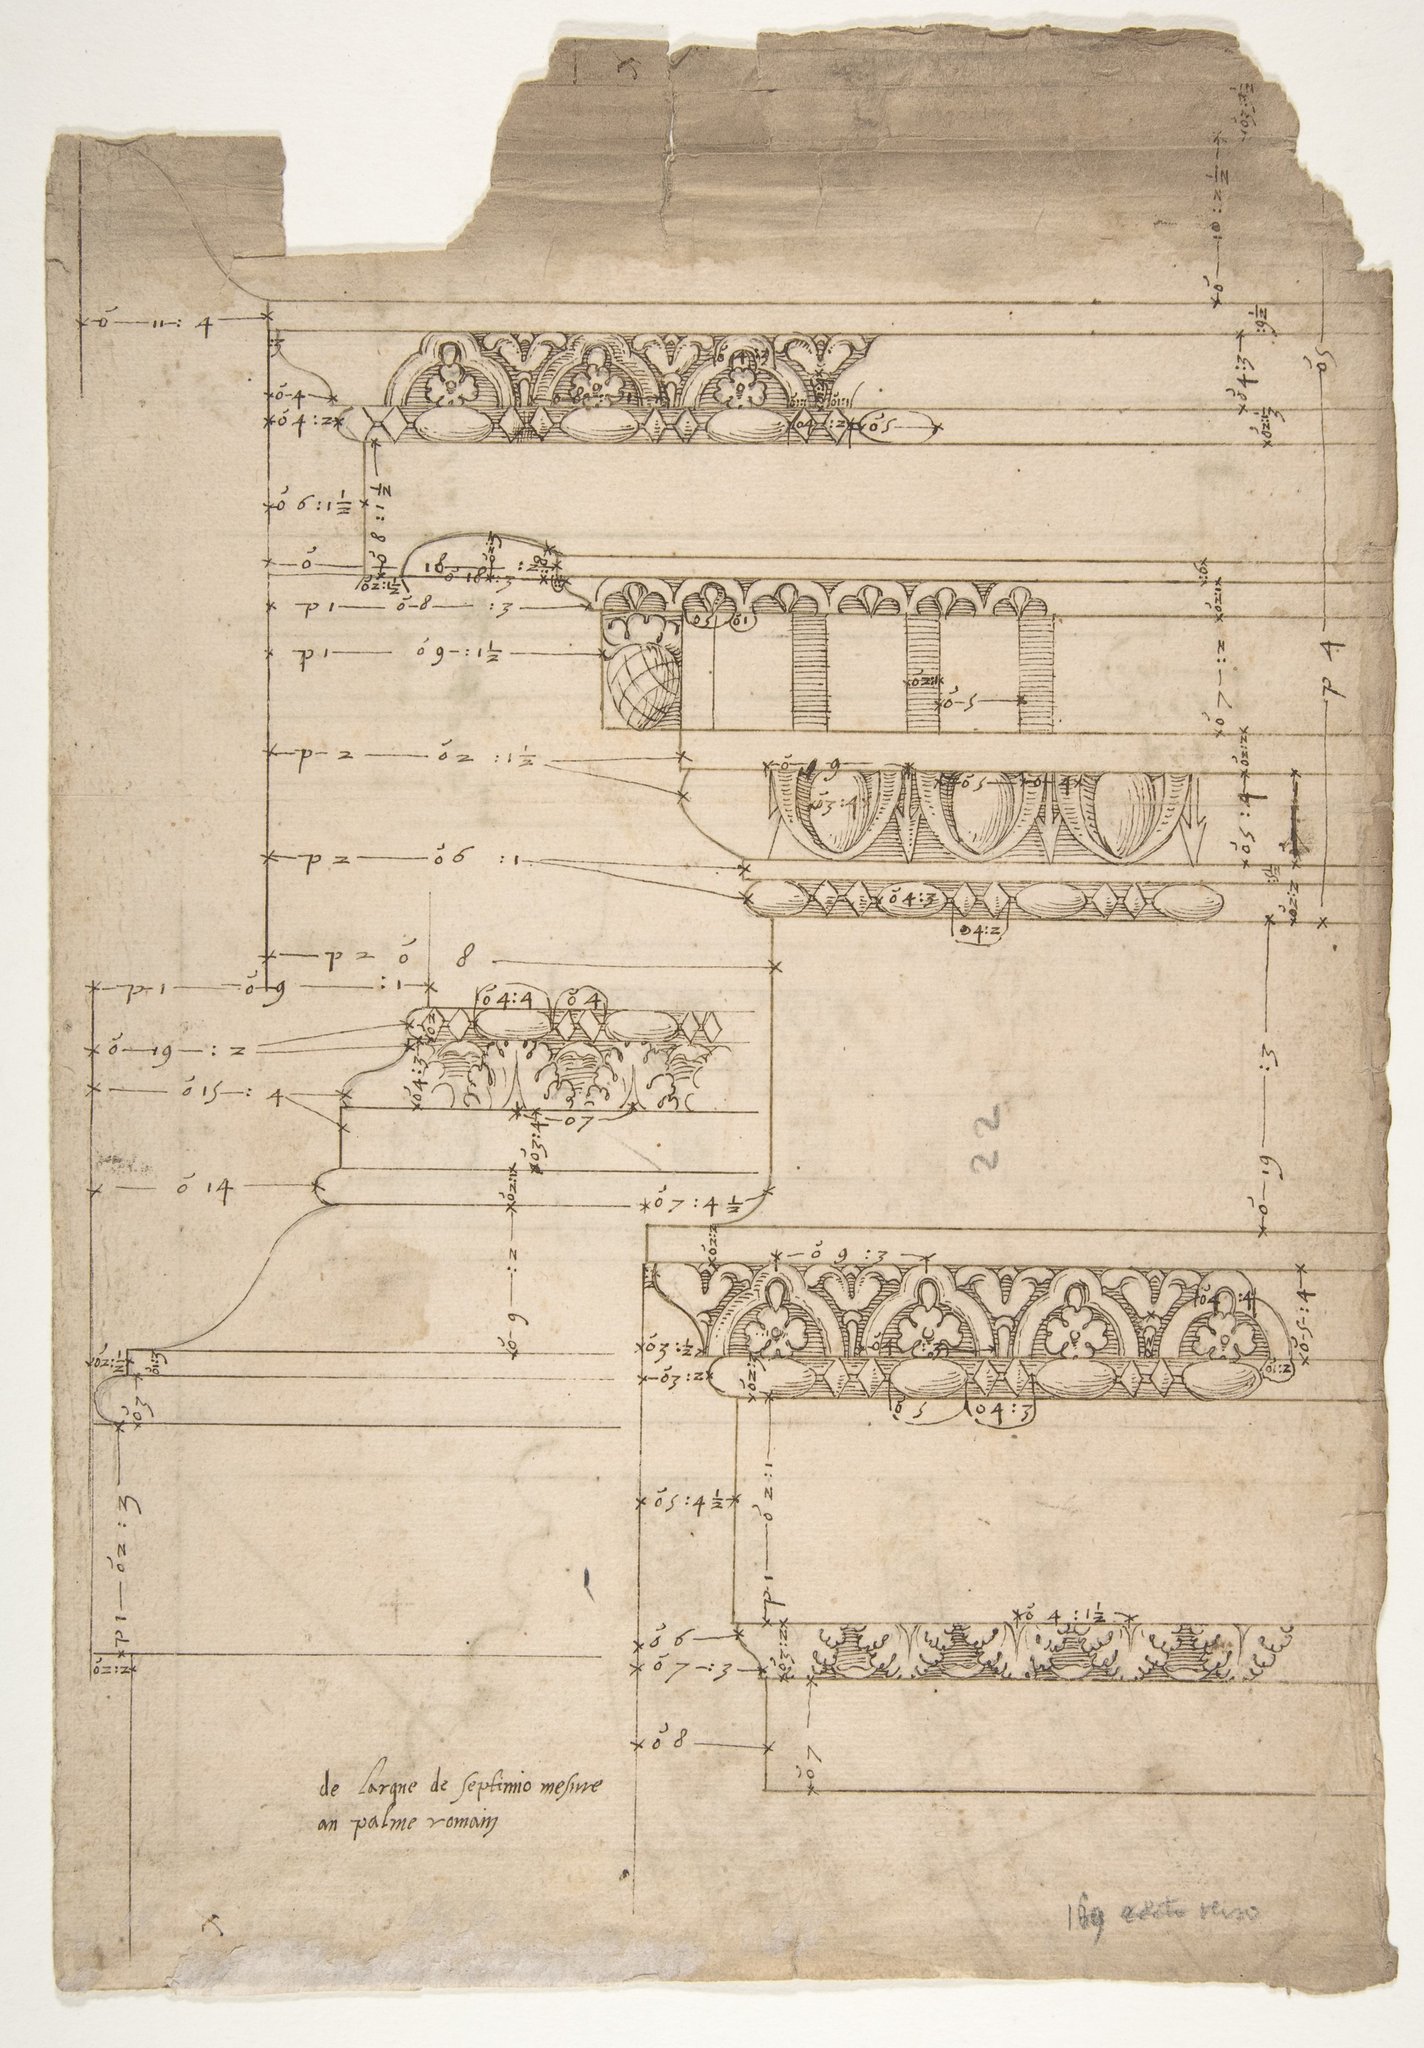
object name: collection ornament architecture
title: Arch of Septimius Severus, entablature, elevation; attic, base, elevation (recto) Arch of Septimius Severus, archivolt, elevation; impost, elevation; entablature, elevation; column base, elevation; column, plan (verso)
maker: anonymous, french, 16th century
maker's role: draftsman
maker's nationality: french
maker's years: 1500-1600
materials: chalk, ink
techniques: incising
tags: architecture